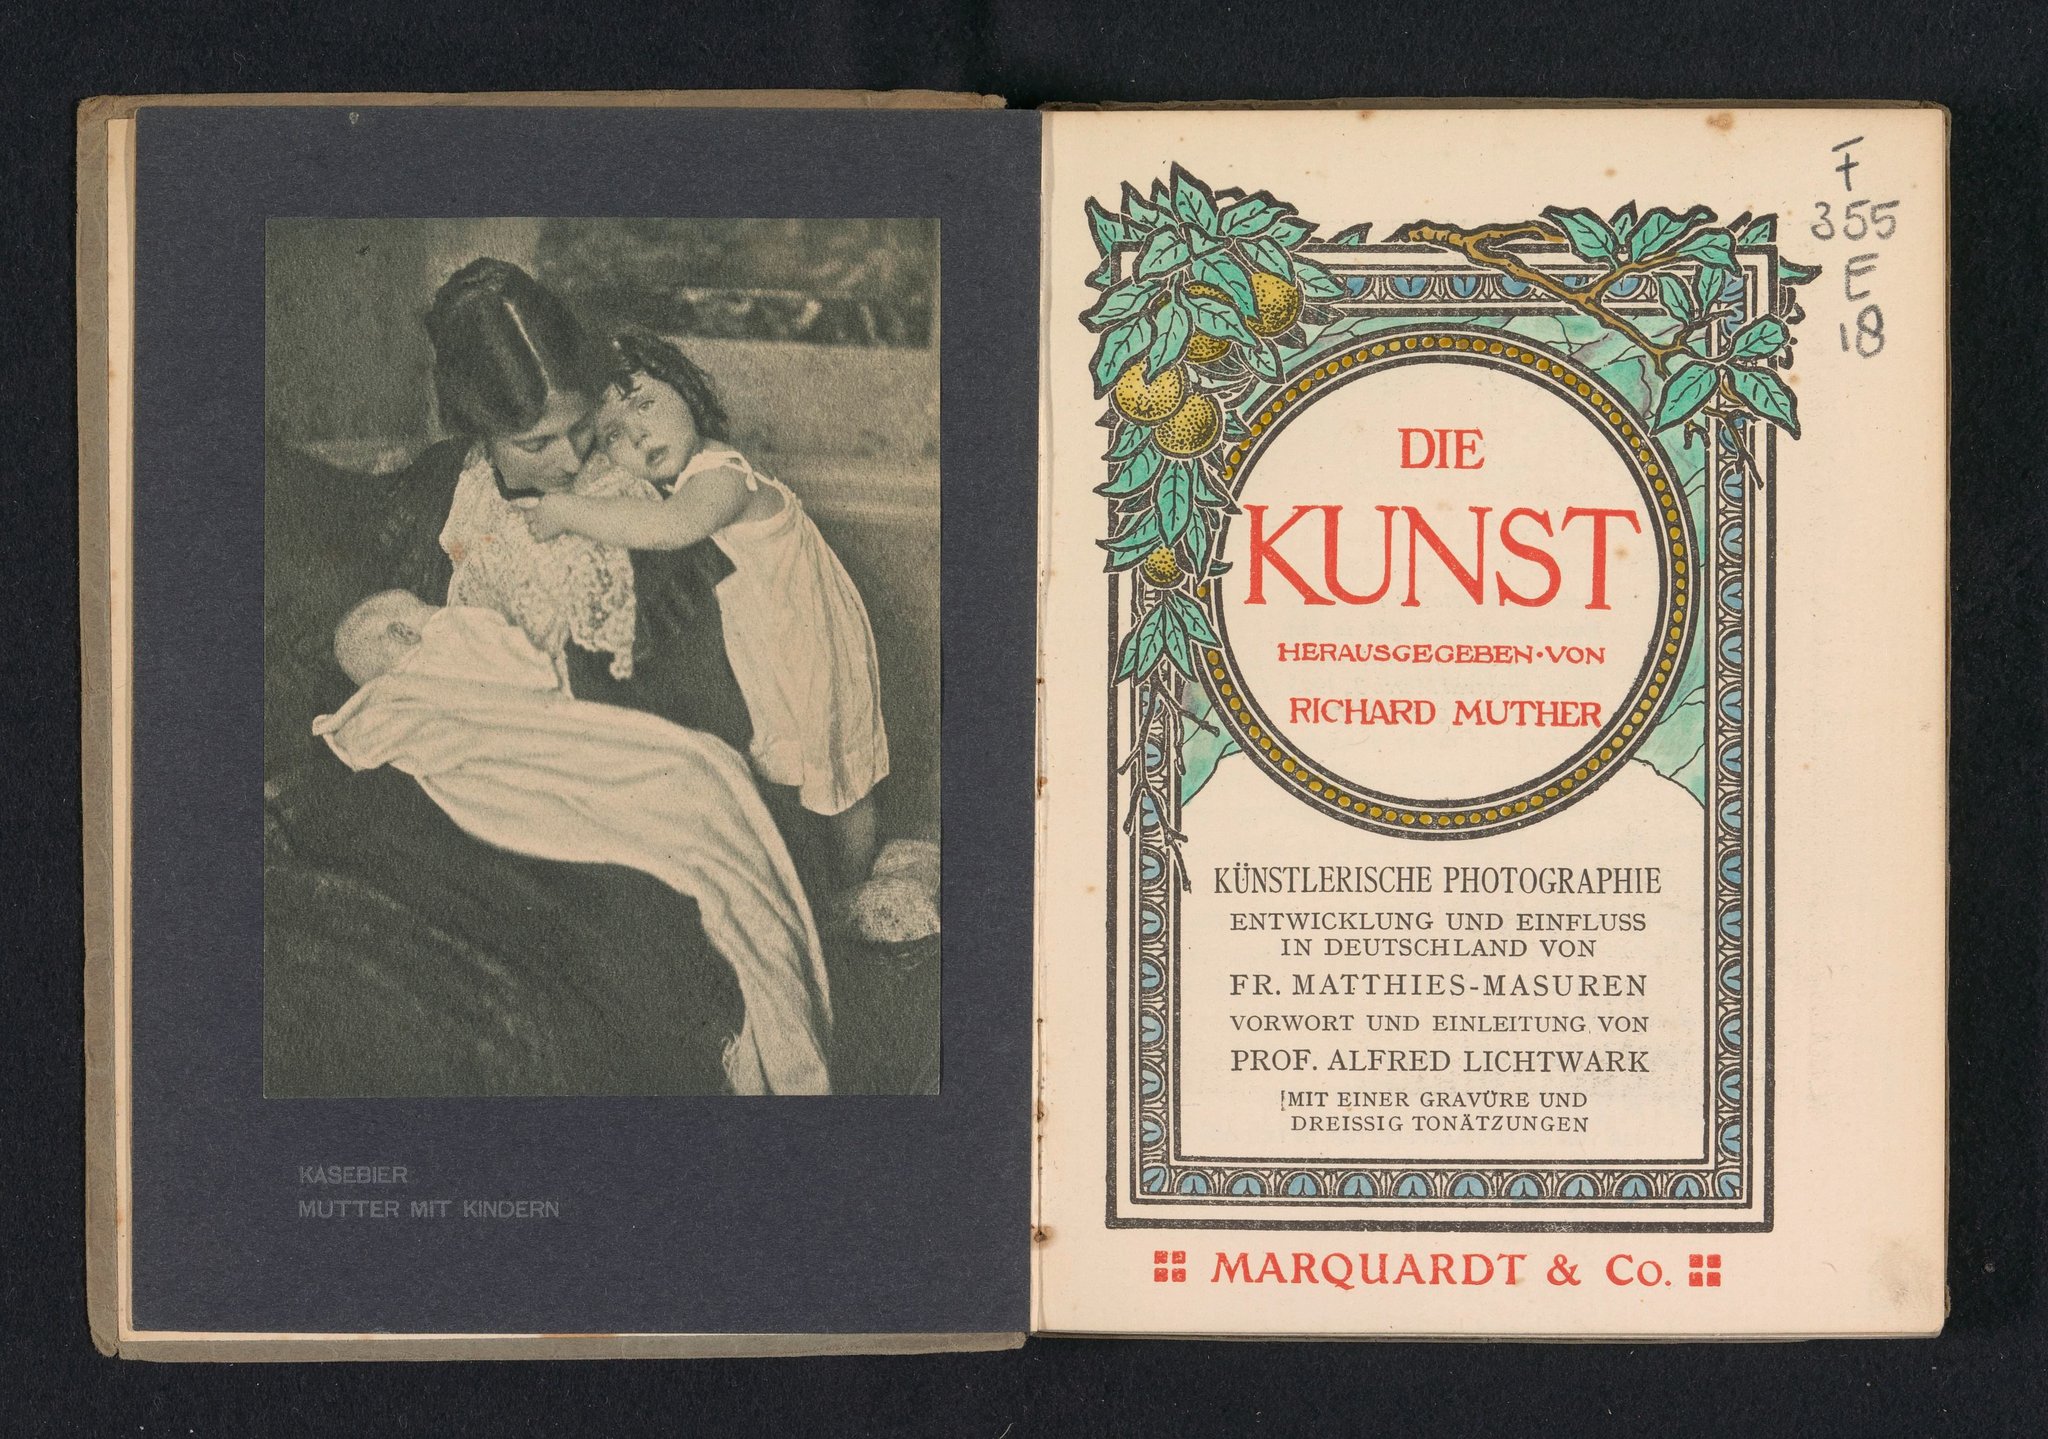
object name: book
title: Künstlerische Photographie : Entwicklung und Einfluss in Deutschland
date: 1917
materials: paper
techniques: rotogravure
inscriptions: name: ‘Lt. [...] R. J Hamer [...]Ballonzug 209.’, bookplate: ‘Ex Libris J Hamer’